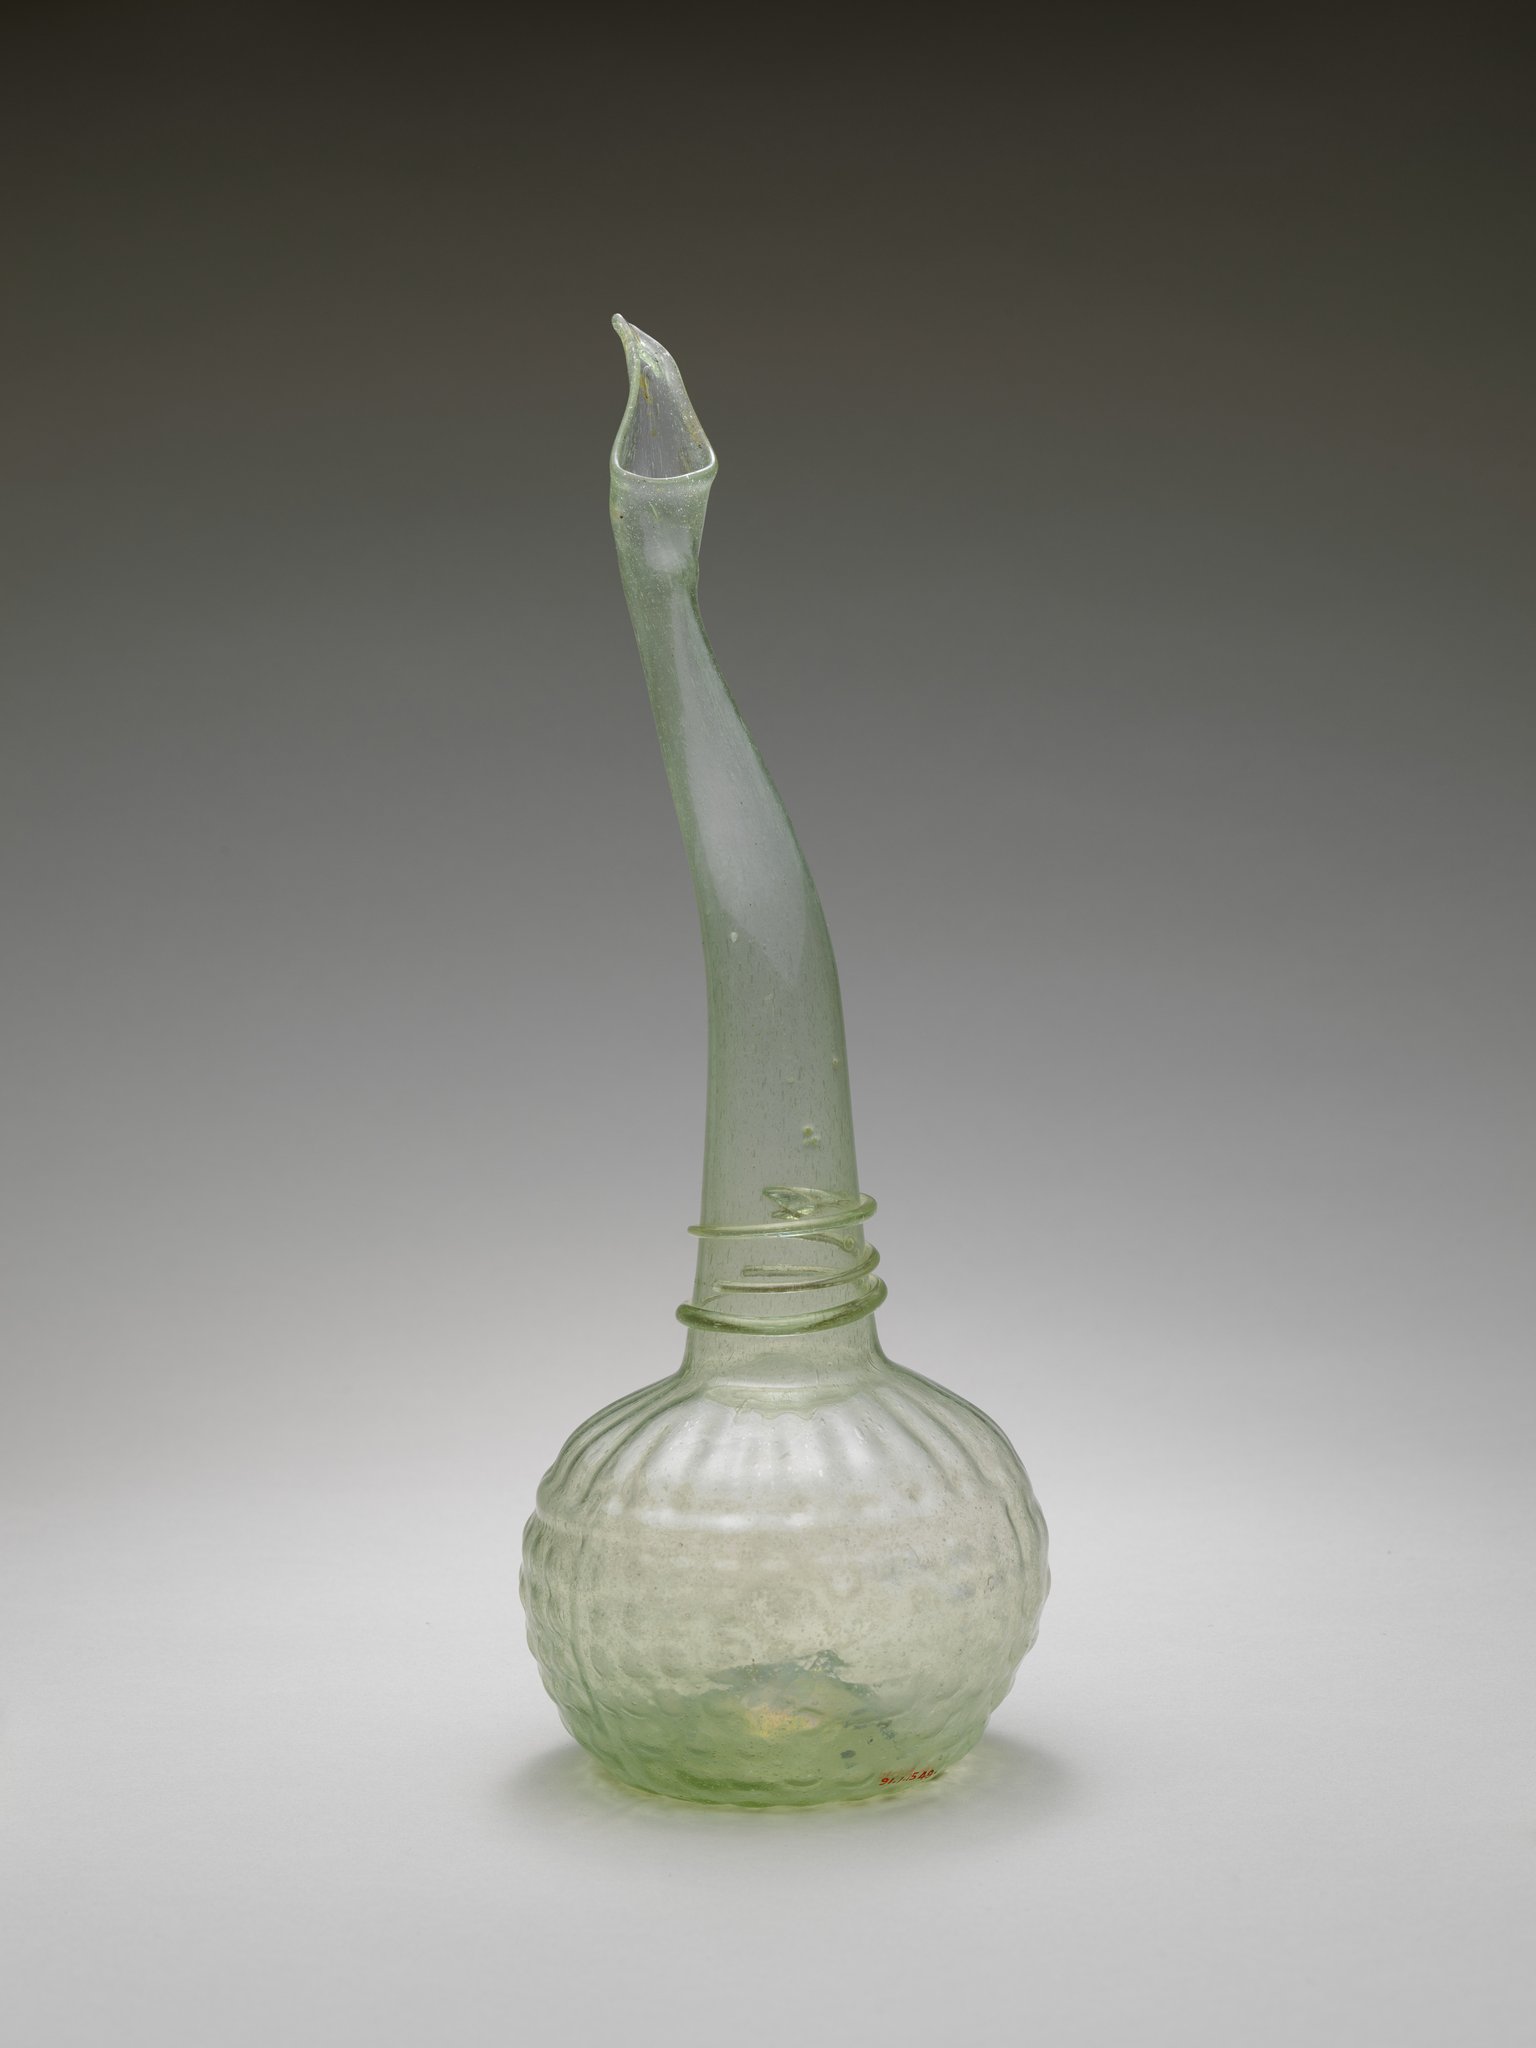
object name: bottle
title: Swan-Neck Bottle (Ashkdan)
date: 1701-1900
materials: glass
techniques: glassblowing, tooling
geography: iran